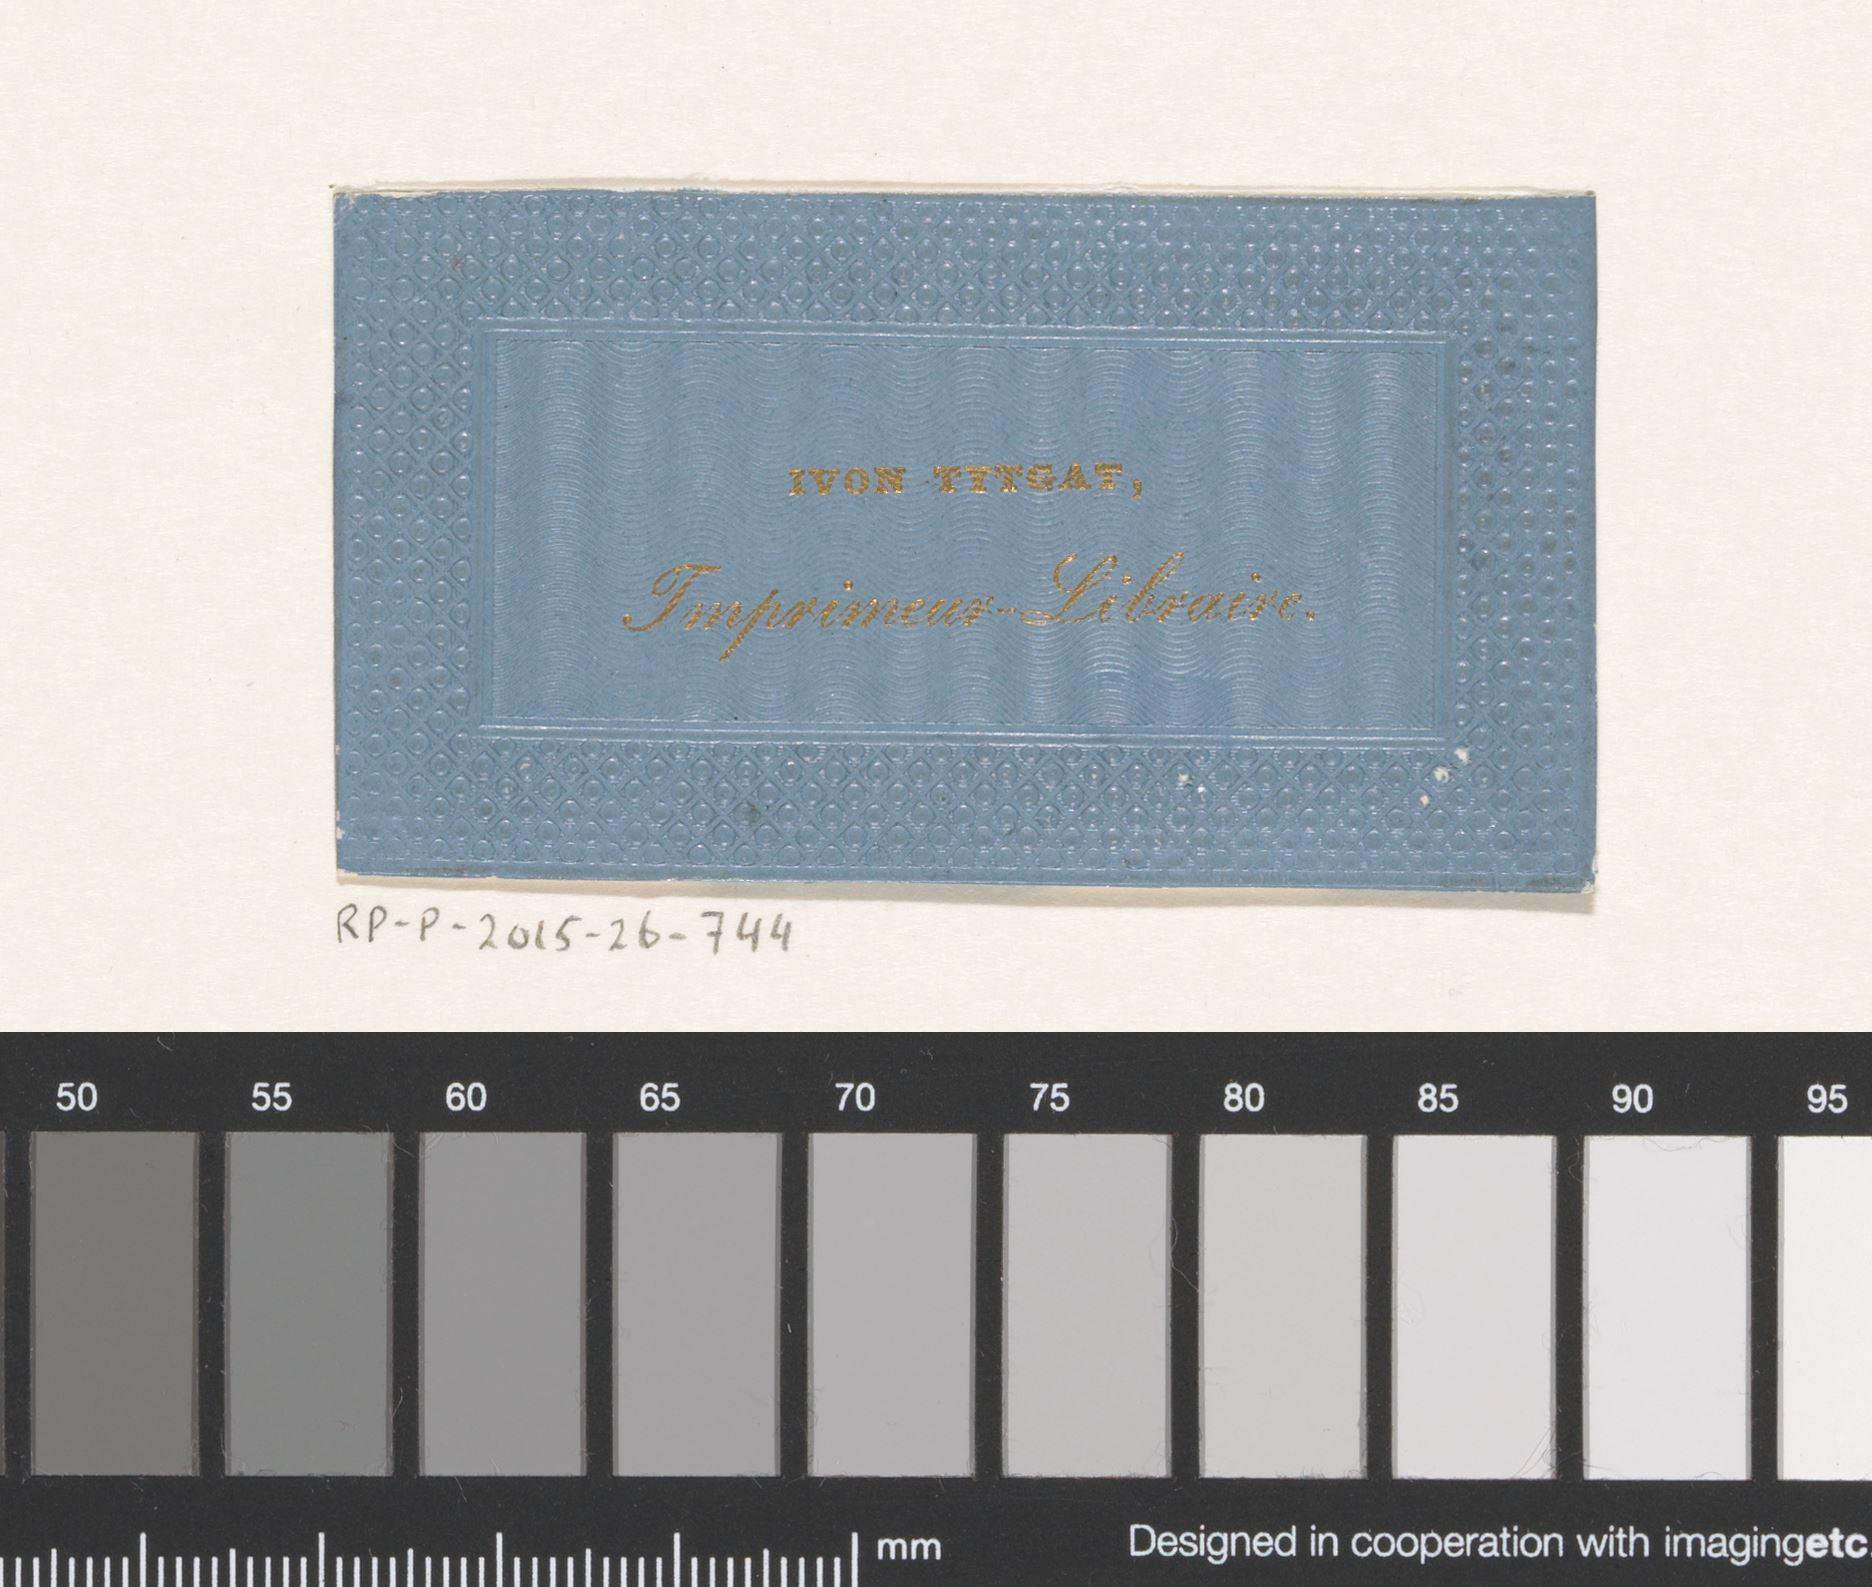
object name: print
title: Visitekaartje van boekhandelaar en drukker Ivon Tytgat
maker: ivon tytgat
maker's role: printer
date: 1841-1853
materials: cardboard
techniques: blind stamped, letterpress printing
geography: ghent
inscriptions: collector's mark: Lugt 2228